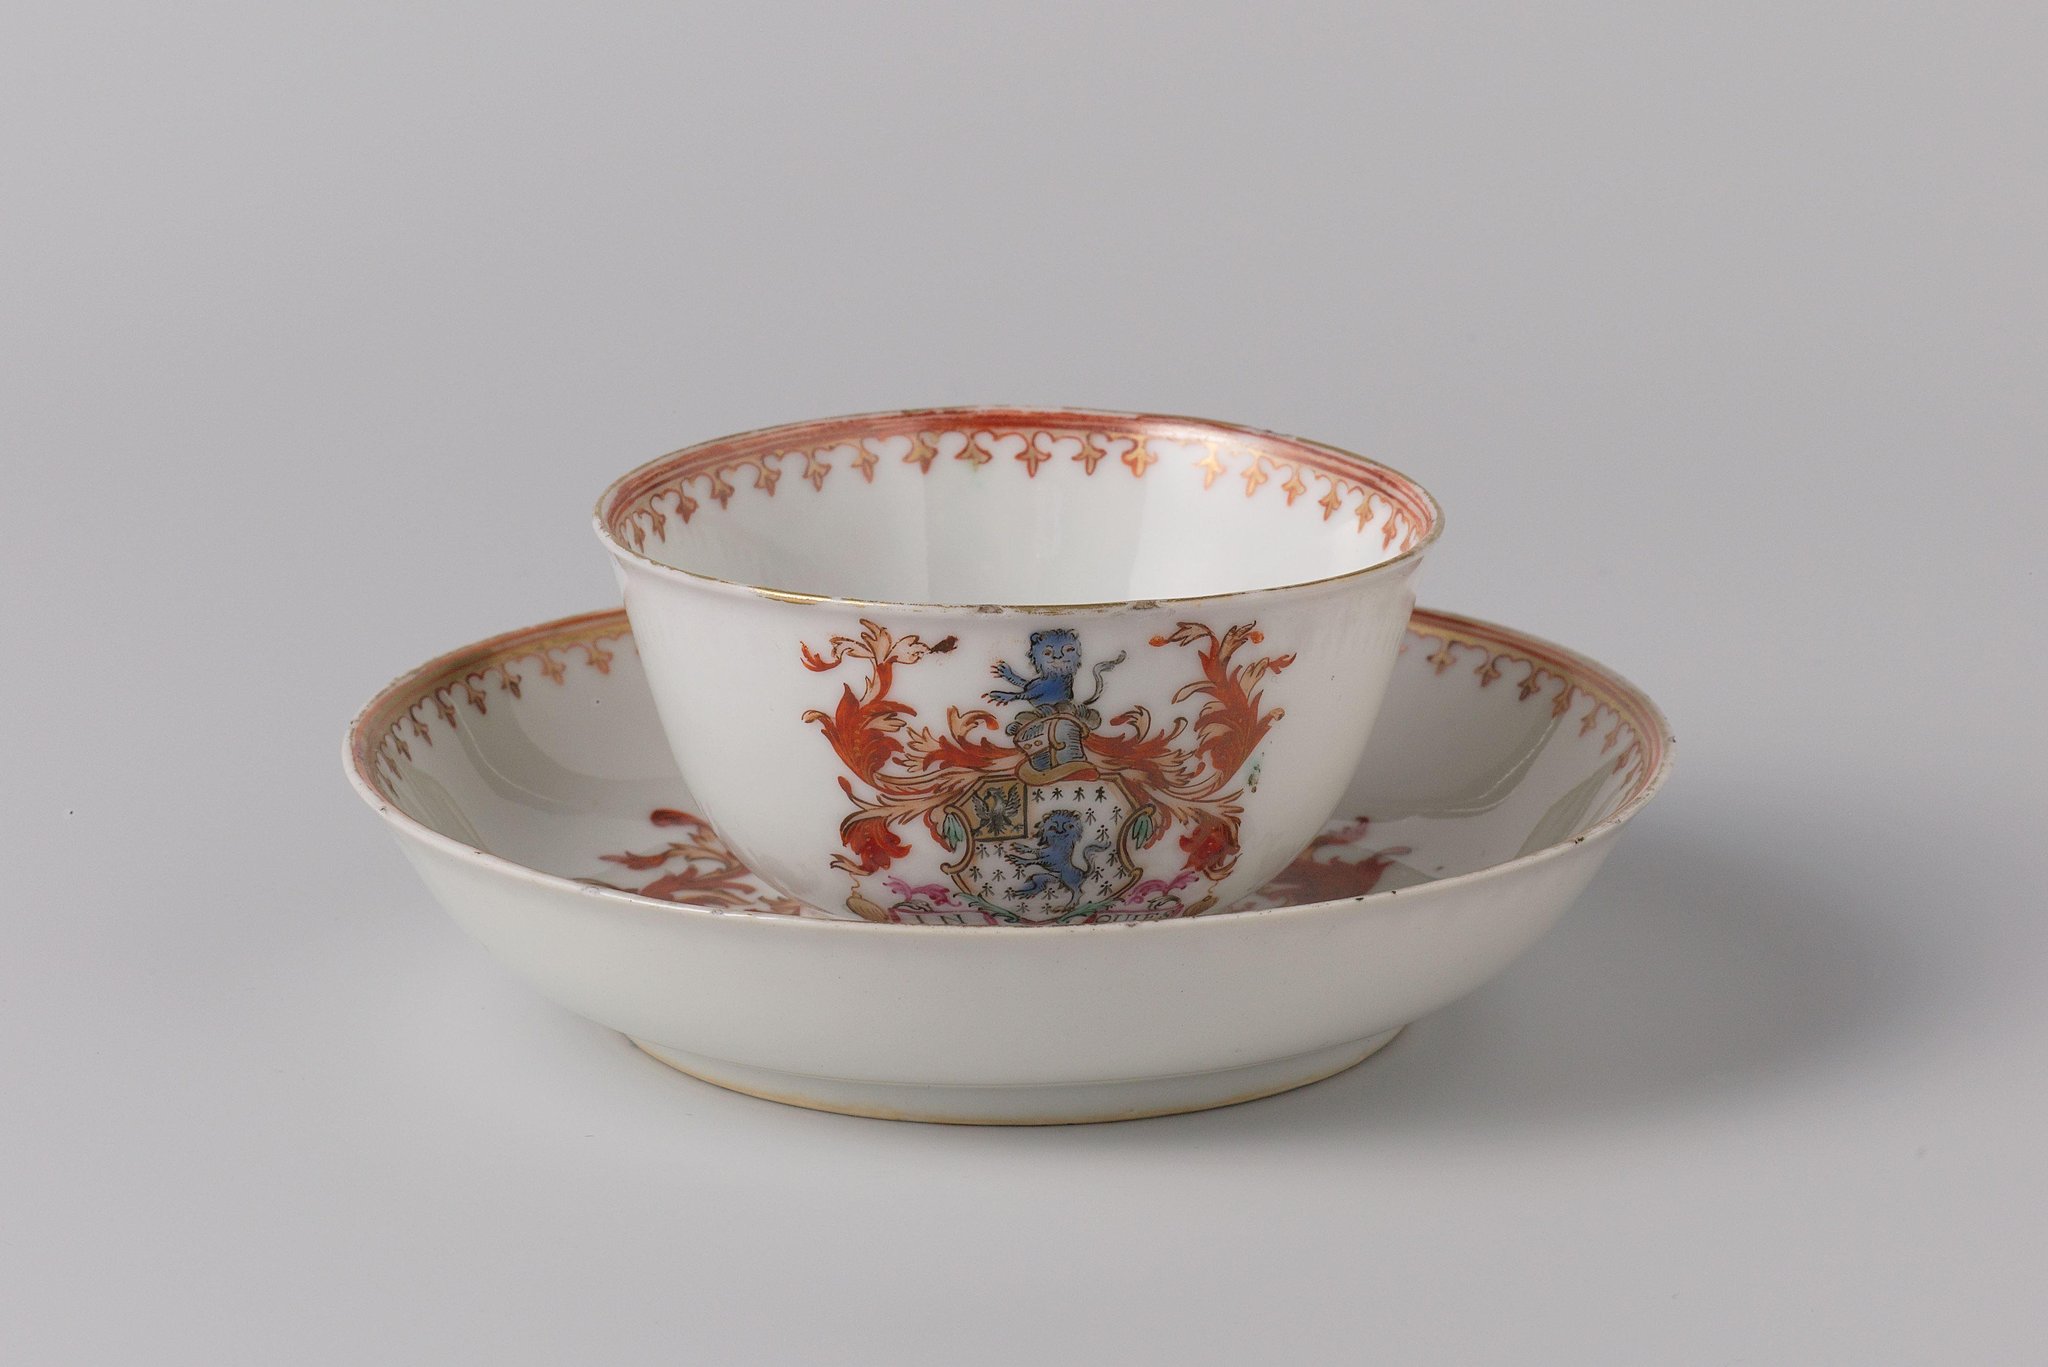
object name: platter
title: Saucer with the arms of the Edwards family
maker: Anonymous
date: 1740-1760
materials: glaze, gold, paint, porcelain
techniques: firing, gilding, turning, vitrification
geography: china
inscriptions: label: ‘Edwards of Iyrington, Norfolk’, inscription: ‘IN CAELO QUIES’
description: Schotel van porselein, beschilderd op het glazuur in blauw, rood, roze, groen, zwart en goud. Op het plat het wapen van de familie Edwards met een blauwe leeuw op een witte achtergrond met zwarte tekens; in de linker hoek een vak met een adelaar. Het helmteken is ook een blauwe leeuw, omgeven door acanthusbladeren. Onder het wapen een banderol met het opschrift 'IN CAELO QUIES', 'de rust komt in de hemel'. Op de binnenrand een spearhead-border. Oud label op de onderzijde met 'Edwards of Iyrington, Norfolk'. Enkele chips in de rand van de schotel. Wapenporselein met emailkleuren.